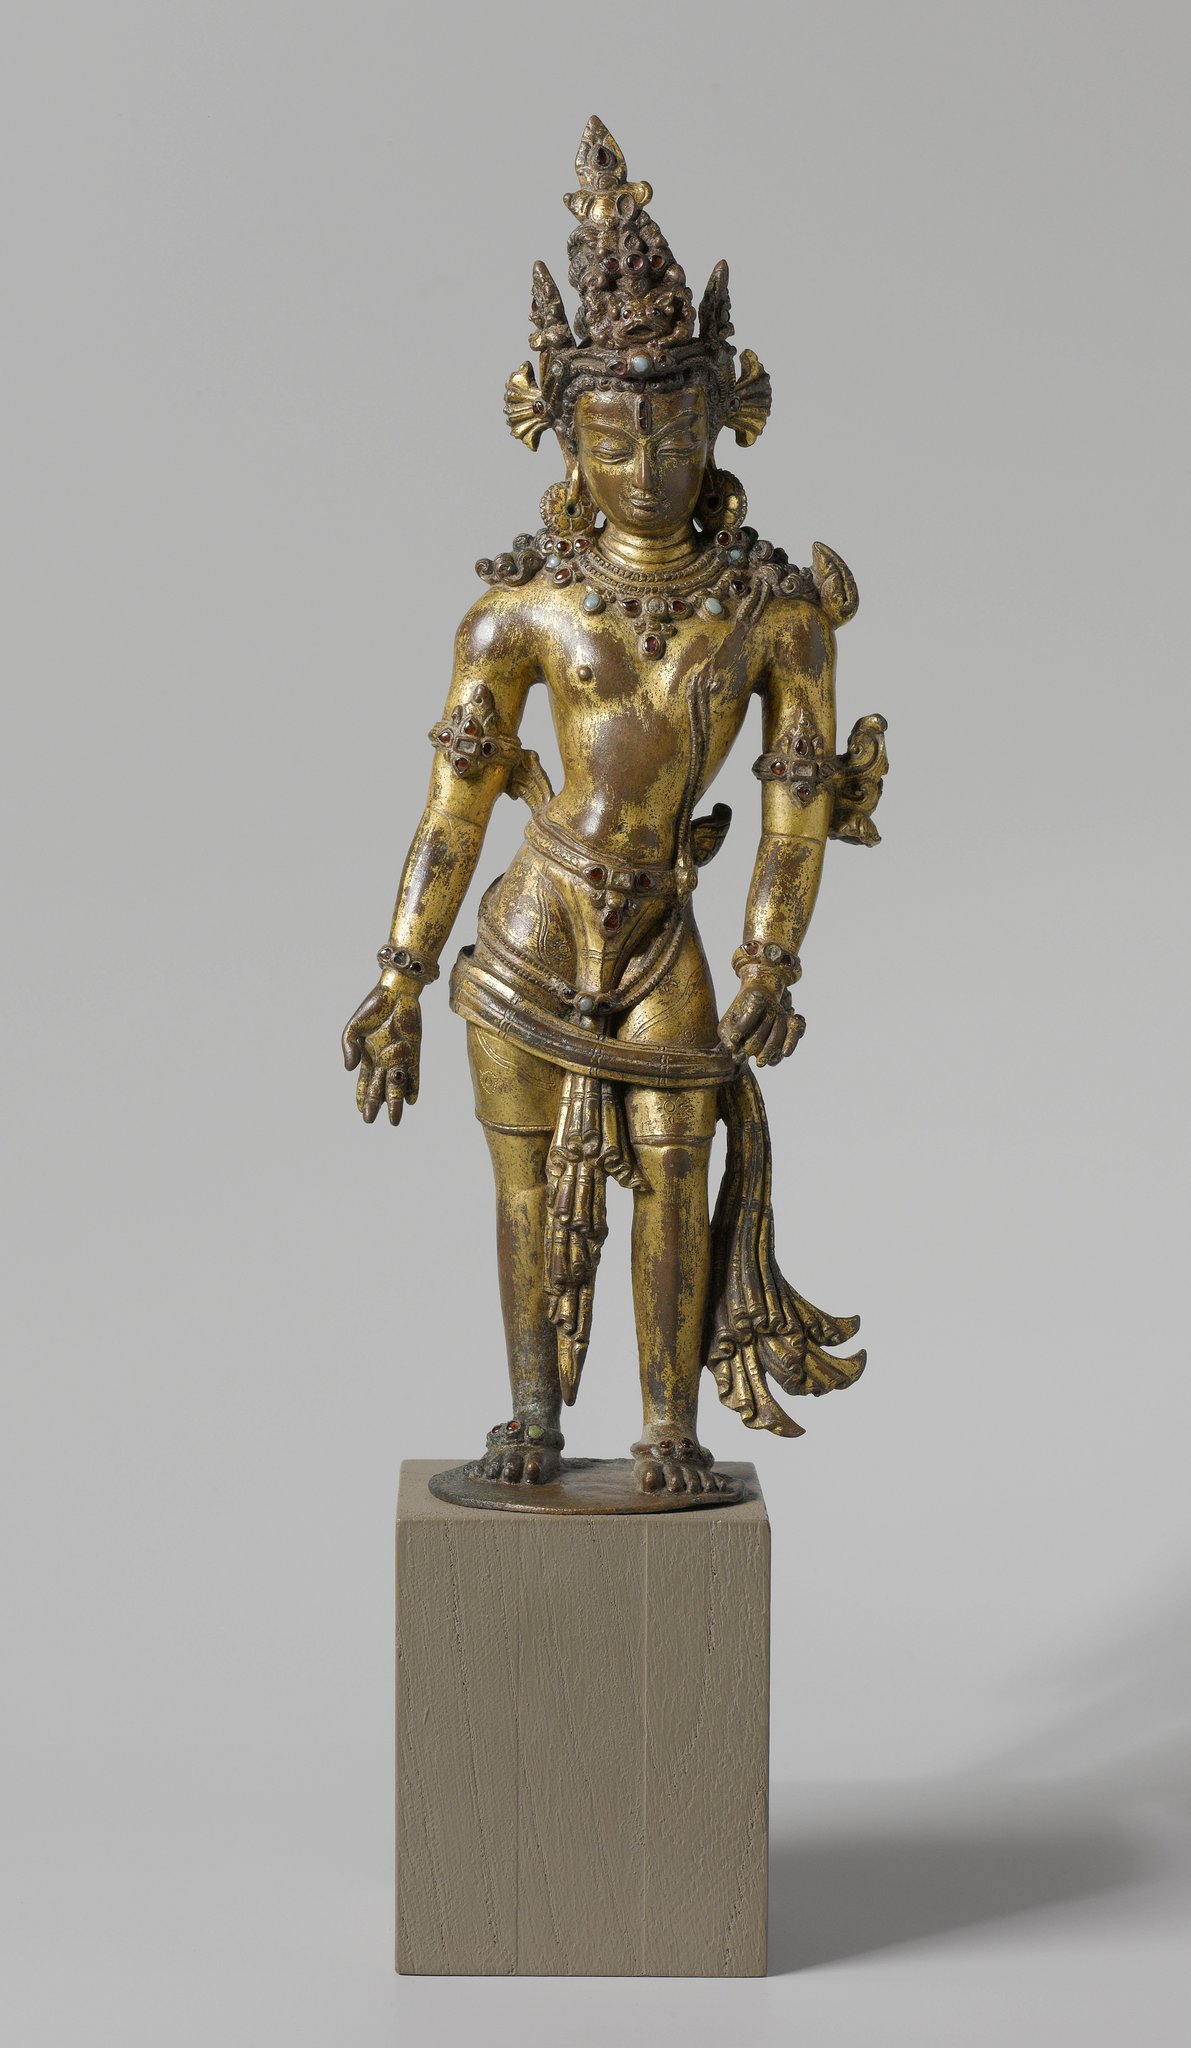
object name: sculpture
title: The Bodhisattva Padmapani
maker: Anonymous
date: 1300-1400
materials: bronze, gemstone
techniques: gilding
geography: nepal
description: Padmapani (‘the lotus bearer’) is a form of the bodhisattva Avalokiteshvara. Now gone, the lotus was probably held in his left hand. Avalokiteshvara is one of the most popular bodhisattvas, revered by Buddhists for his infinite compassion and assistance in times of need.